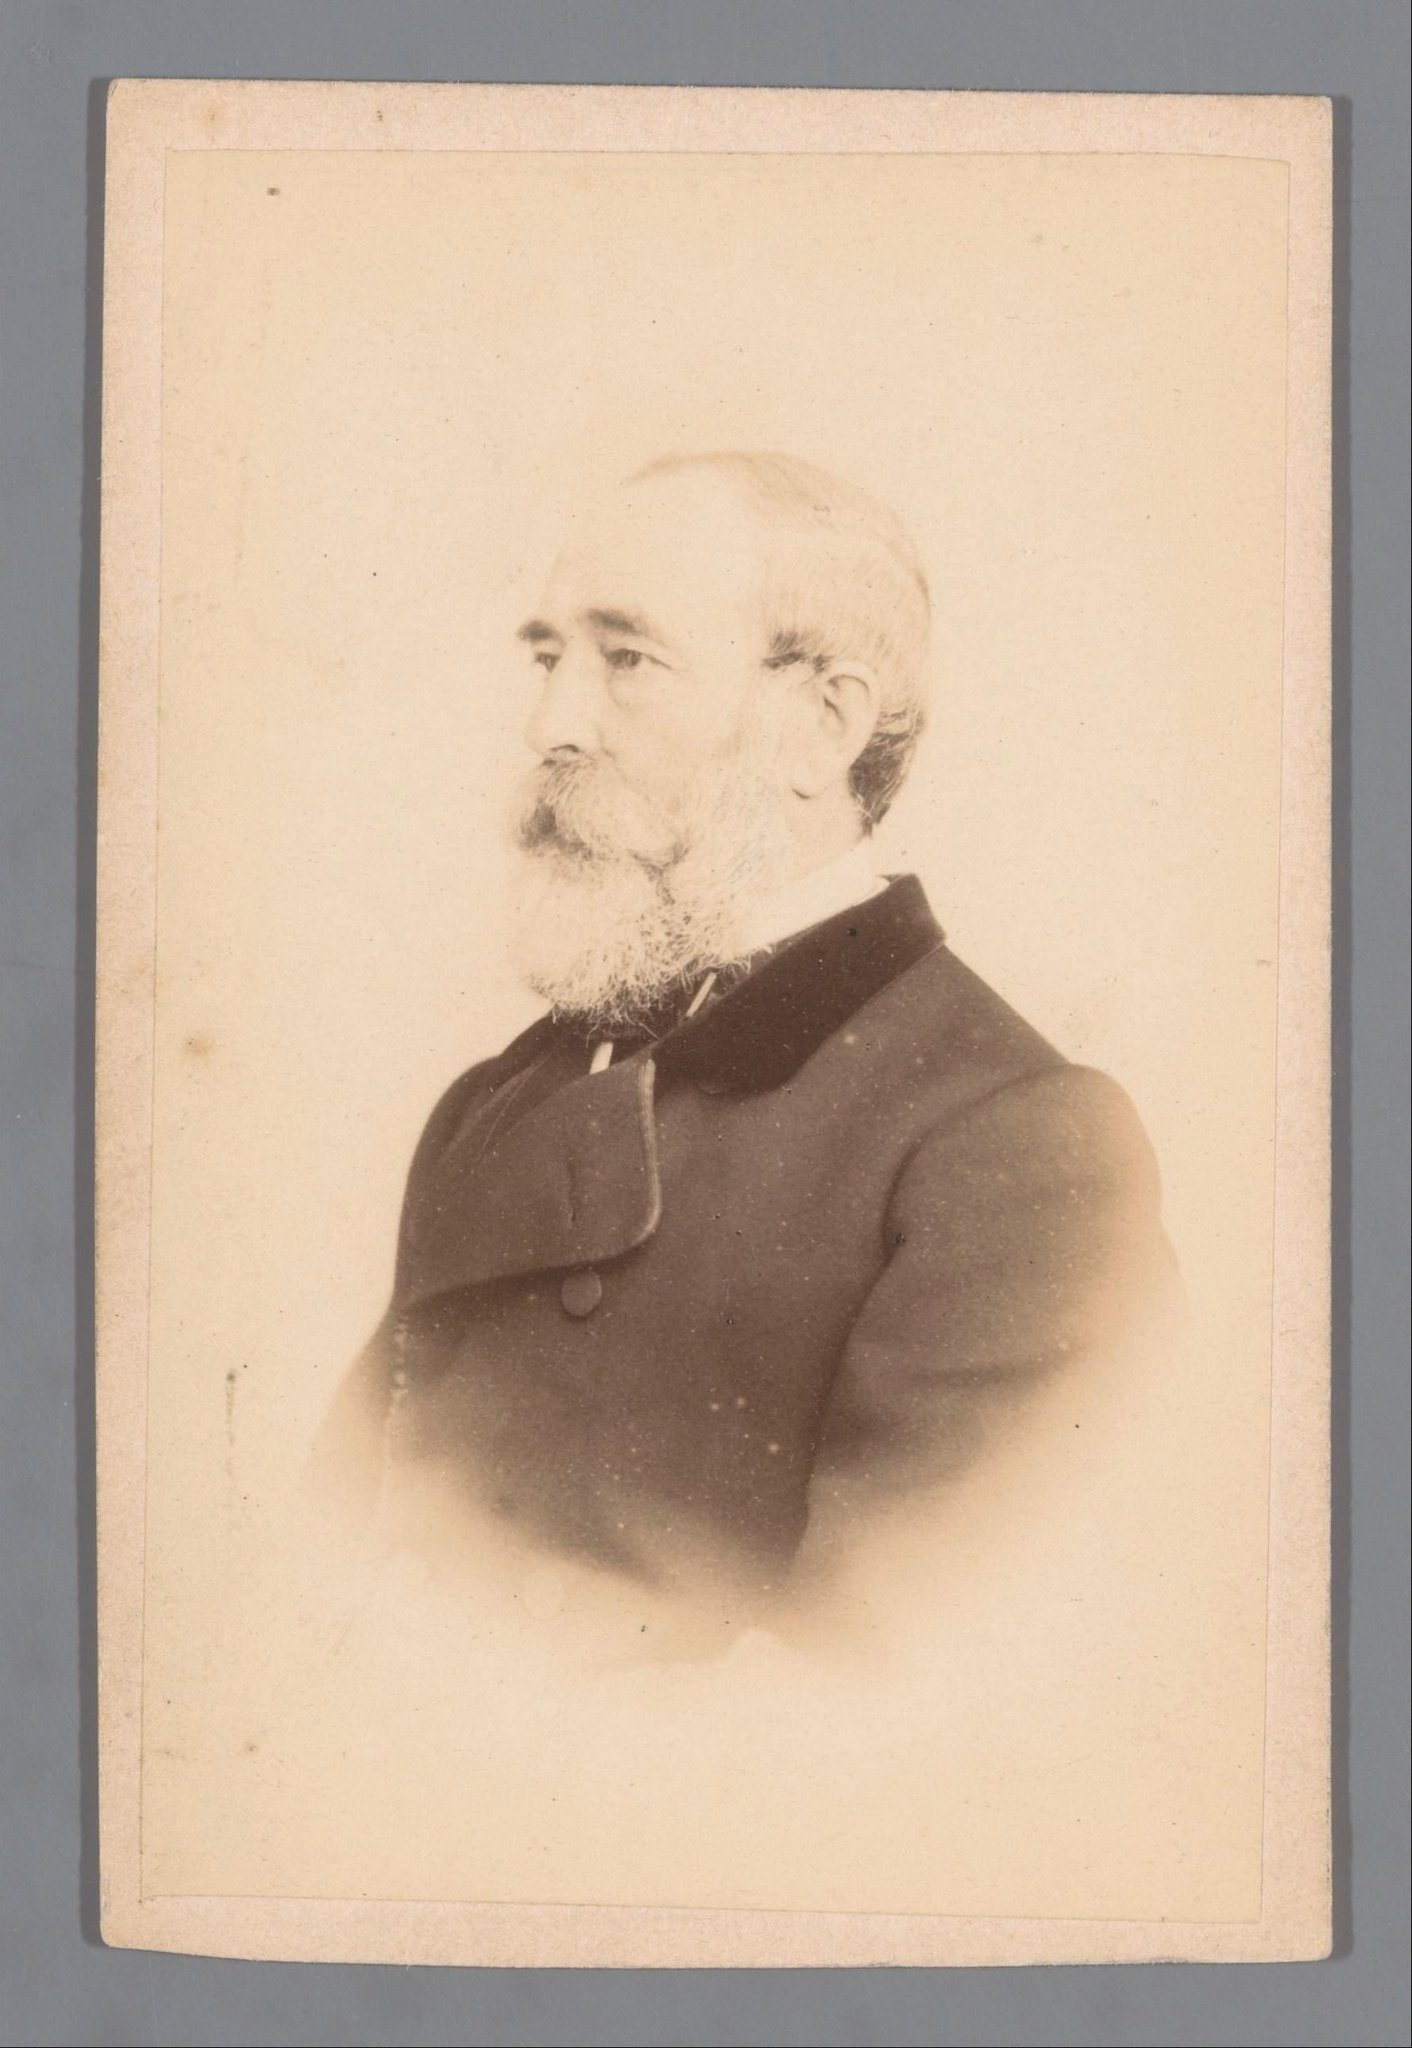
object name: carte de visite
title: Portret van de amateurschilder Ed. Van de Woesteyne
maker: joseph dupont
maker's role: fotograaf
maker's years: 1818-1901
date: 1866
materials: cardboard, photographic support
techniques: albumen print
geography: antwerp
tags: historical persons, portrait, self-portrait of painter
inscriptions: annotation: ‘Capitaine Ed. Van de Woesteyne/ (peintre amateur)/ 1866.’, inscription: ‘Etablissement Photographique/ DE/ J. DUPONT,/ Place de Meir, 32/ Anvers/ Maison fondée en 1853.’